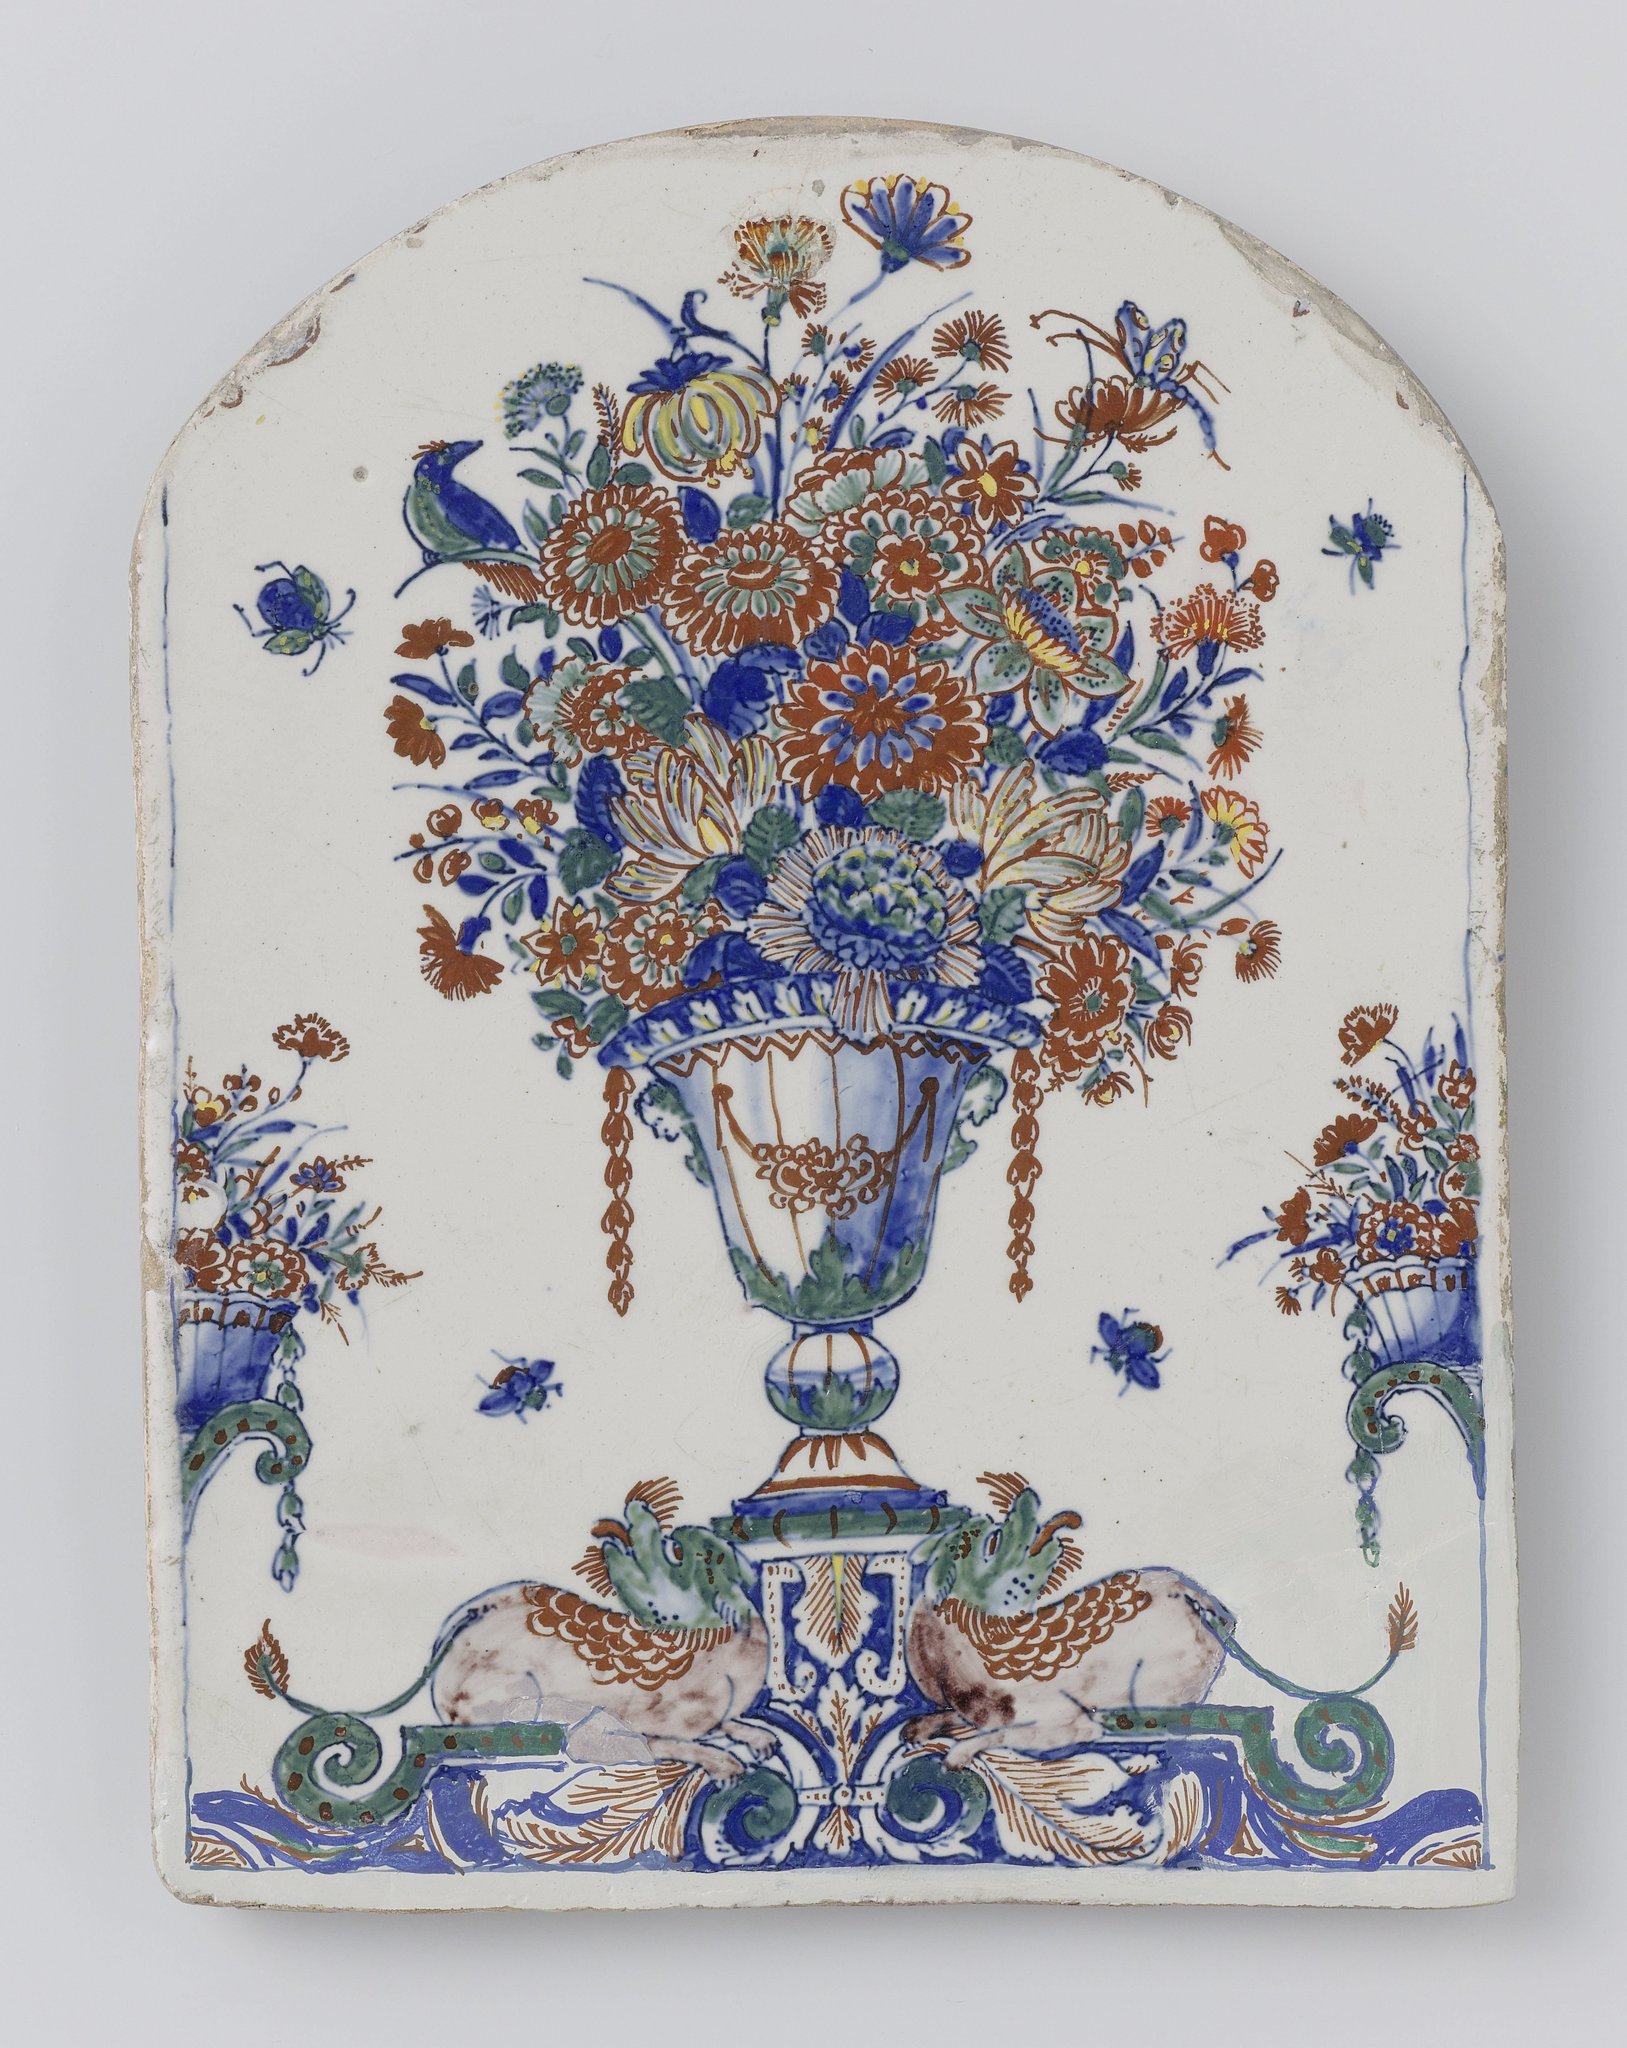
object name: plate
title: Plaat met afgeronde bovenkant en veelkleurig beschilderd met een vaas met bloemen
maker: Anonymous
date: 1700-1730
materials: faience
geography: delft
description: De plaat is een fragment, aan de bovenrand zijn resten van verdere decoraties zichtbaar. Aan de achterkant zijn de randen afgeschuind, waardoor de originele dikte van de plaat niet zichbaar is.